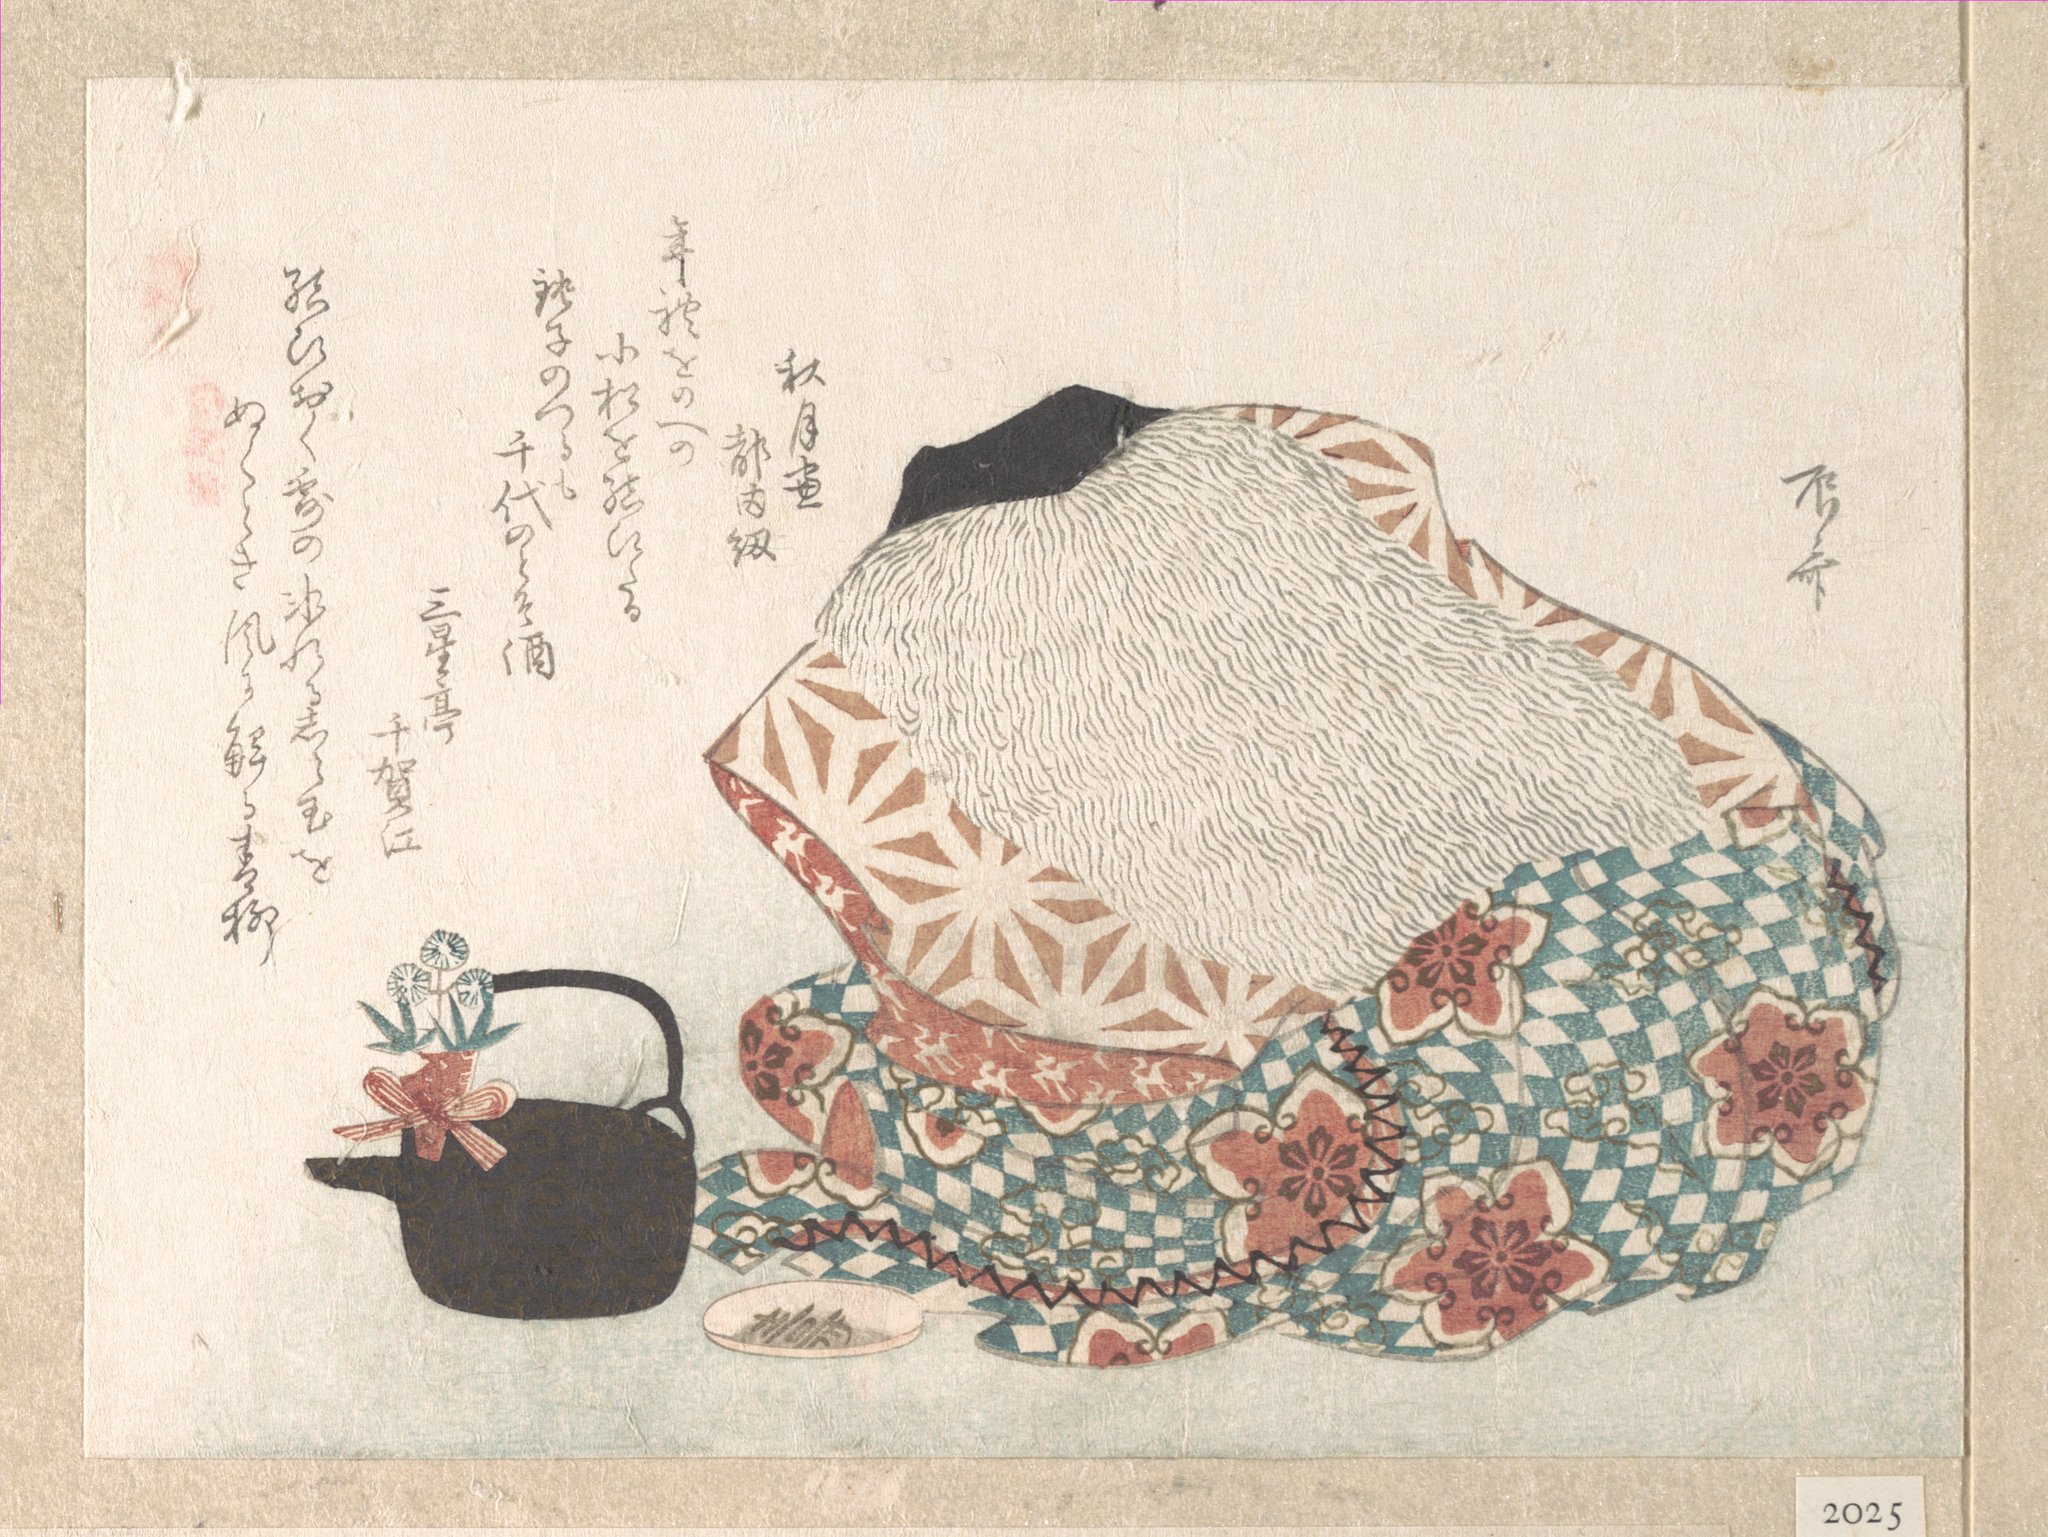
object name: print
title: Outfit for the New Year Ceremony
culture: japanese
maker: ryūryūkyo shinsai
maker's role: artist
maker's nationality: japanese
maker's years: 1799-1823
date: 1801-1900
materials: ink, paper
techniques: surimono, woodblock print